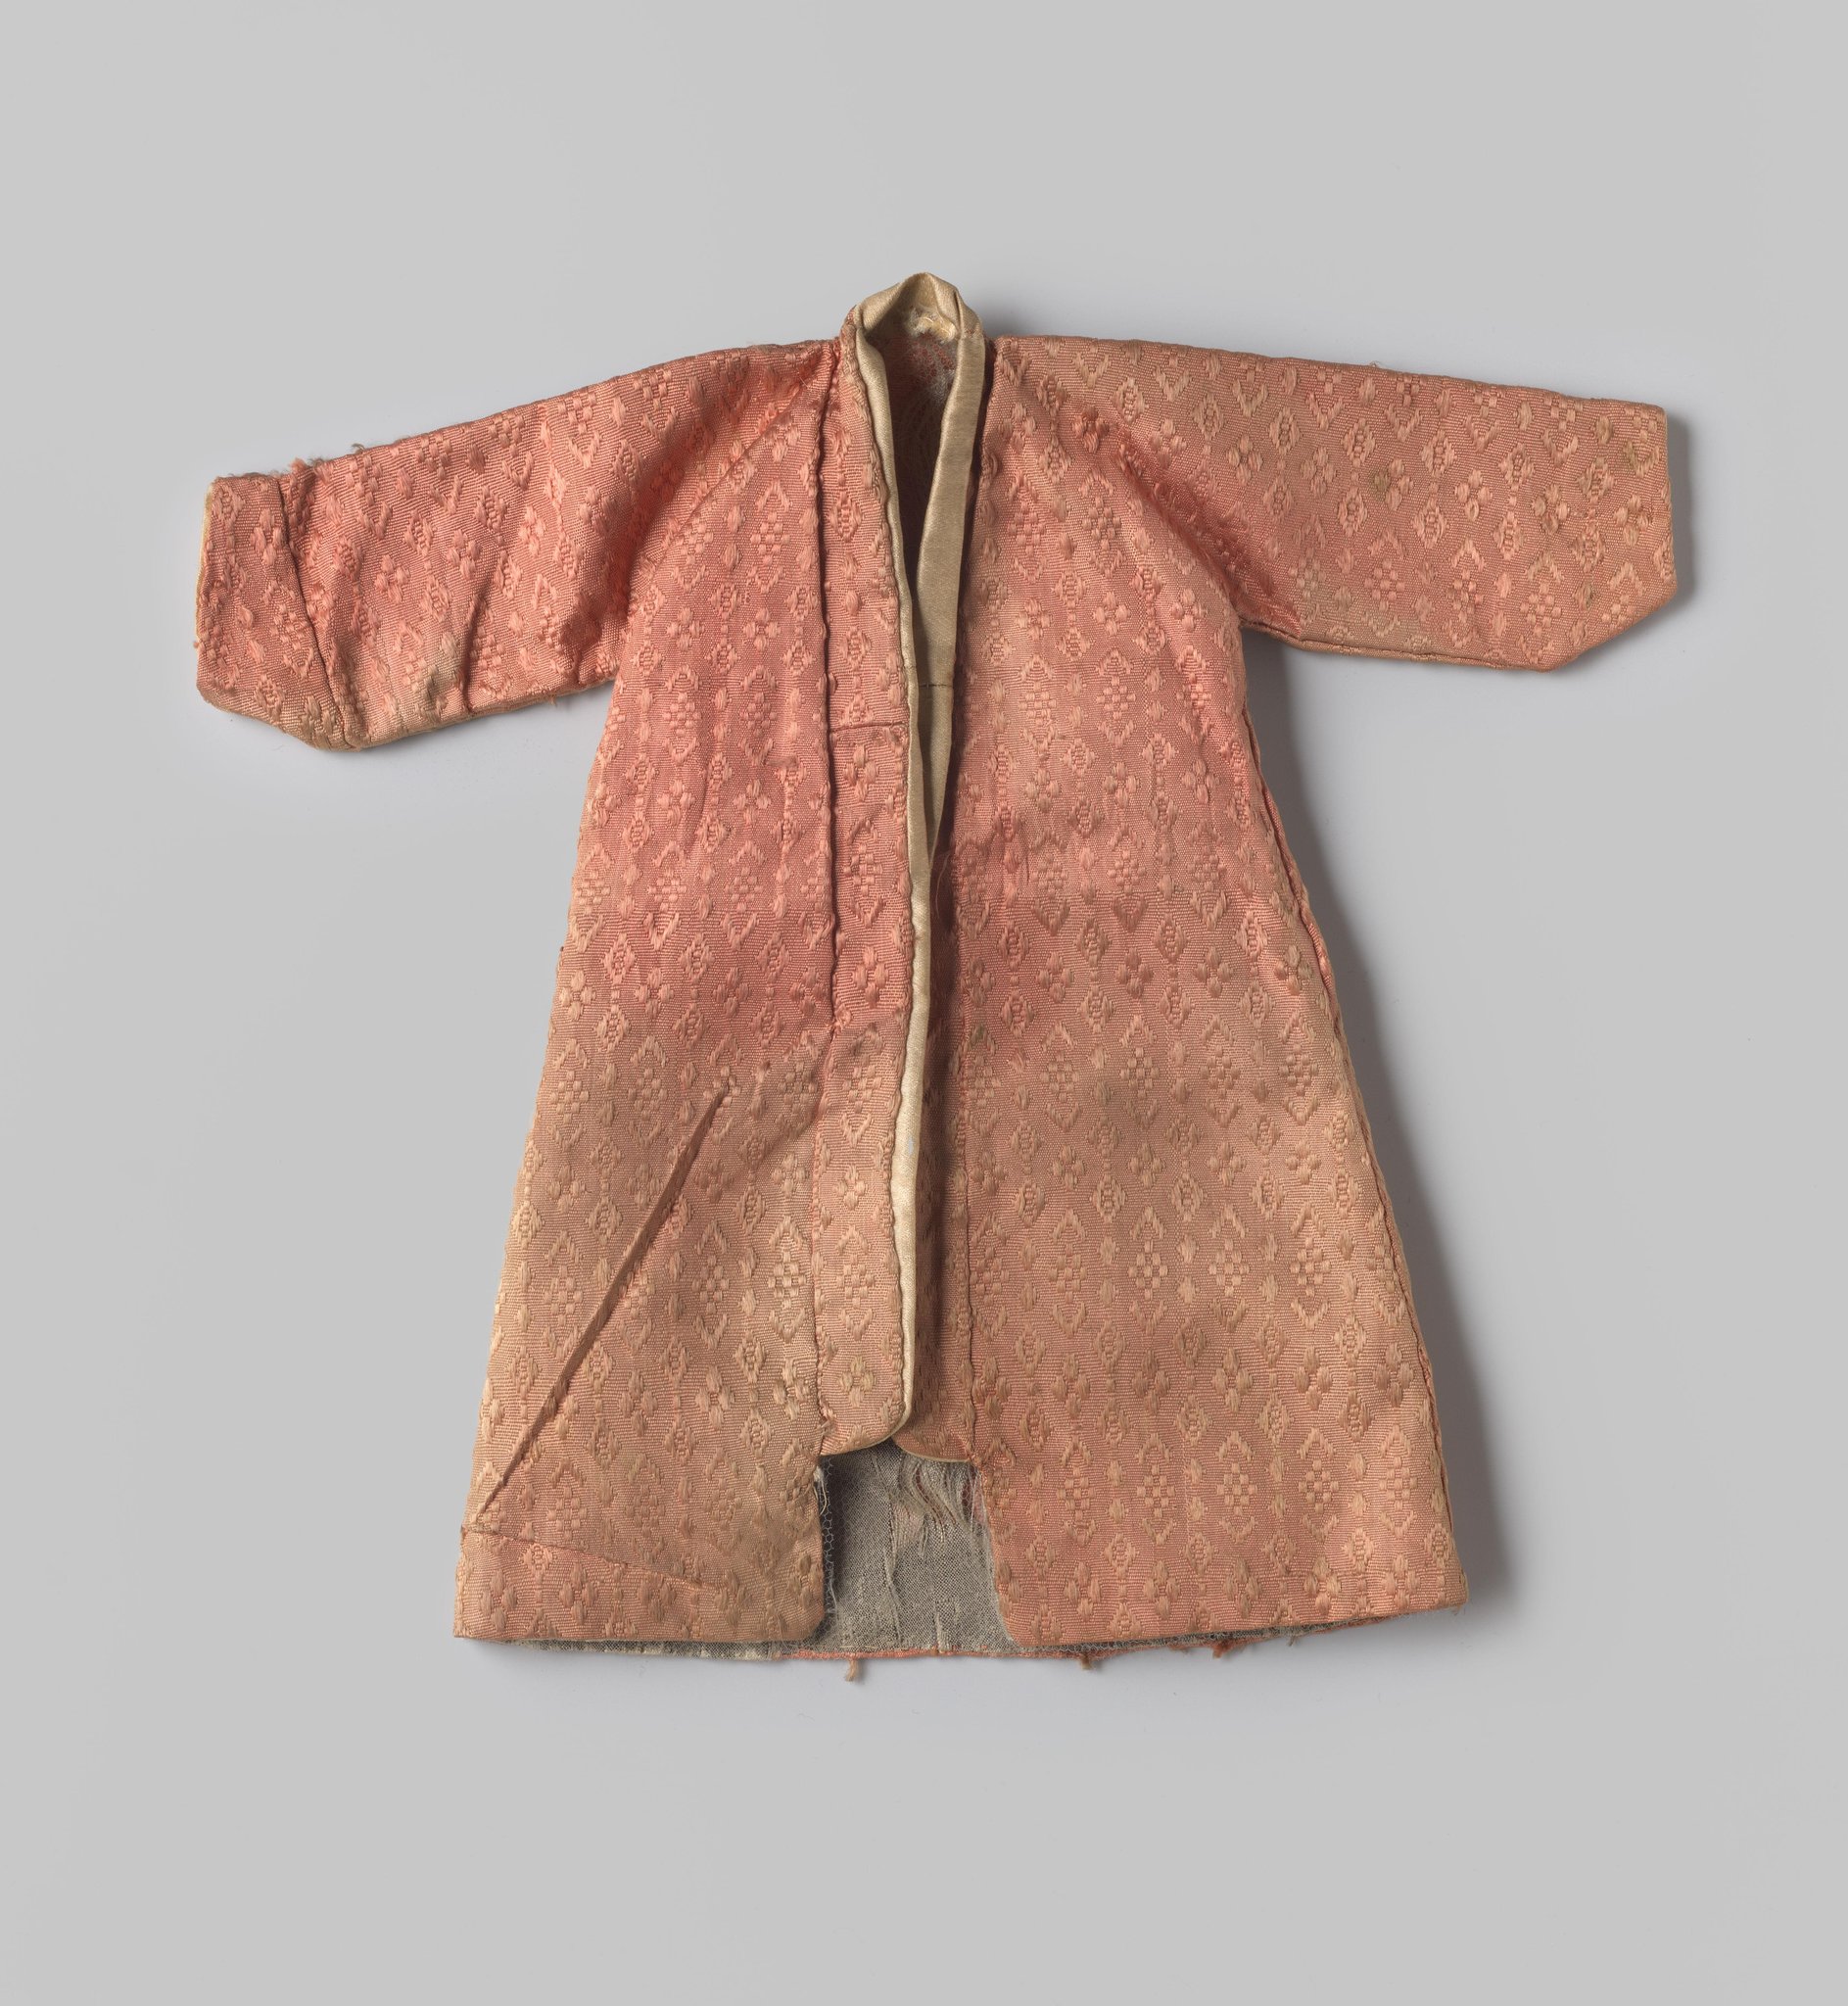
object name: doll's clothing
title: Japonse rok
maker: Anonymous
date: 1690-1710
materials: silk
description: Japonse rok van roze zijde met ingeweven patroon, gevoerd met effen lichtblauwe zijde. Langs de hals is een aangenaaide, bijna tot aan de onderzoom doorlopende kraag vastgezet.